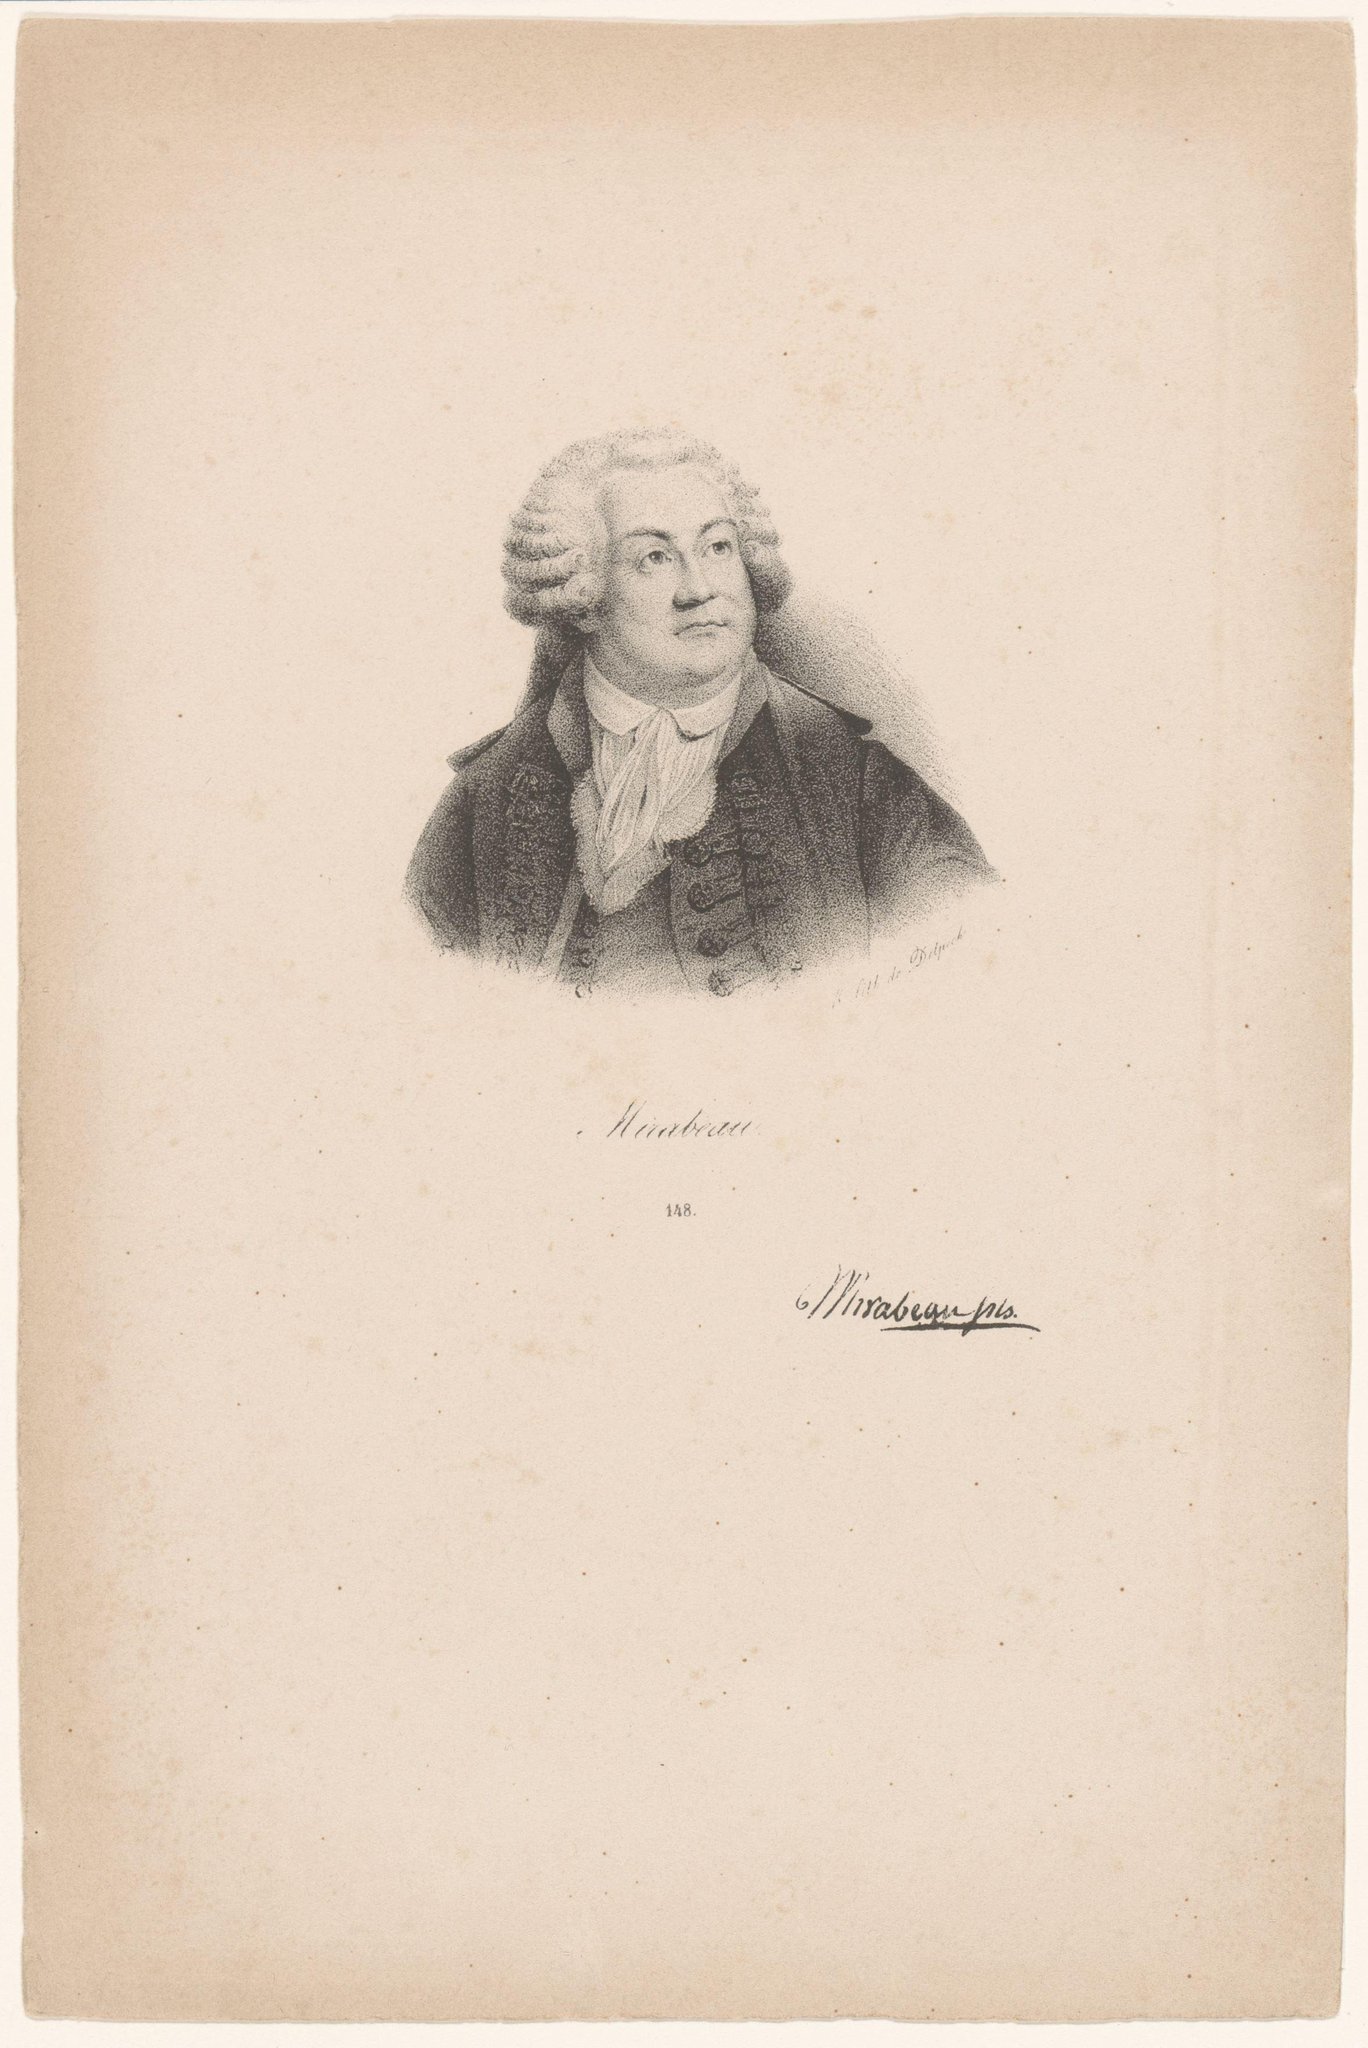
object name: print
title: Mirabeau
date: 1818-1842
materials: paper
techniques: lithograph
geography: paris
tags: paris, politician, honoré-gabriel de riqueti (graaf van mirabeau), historical persons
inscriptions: collector's mark: Lugt 2228a